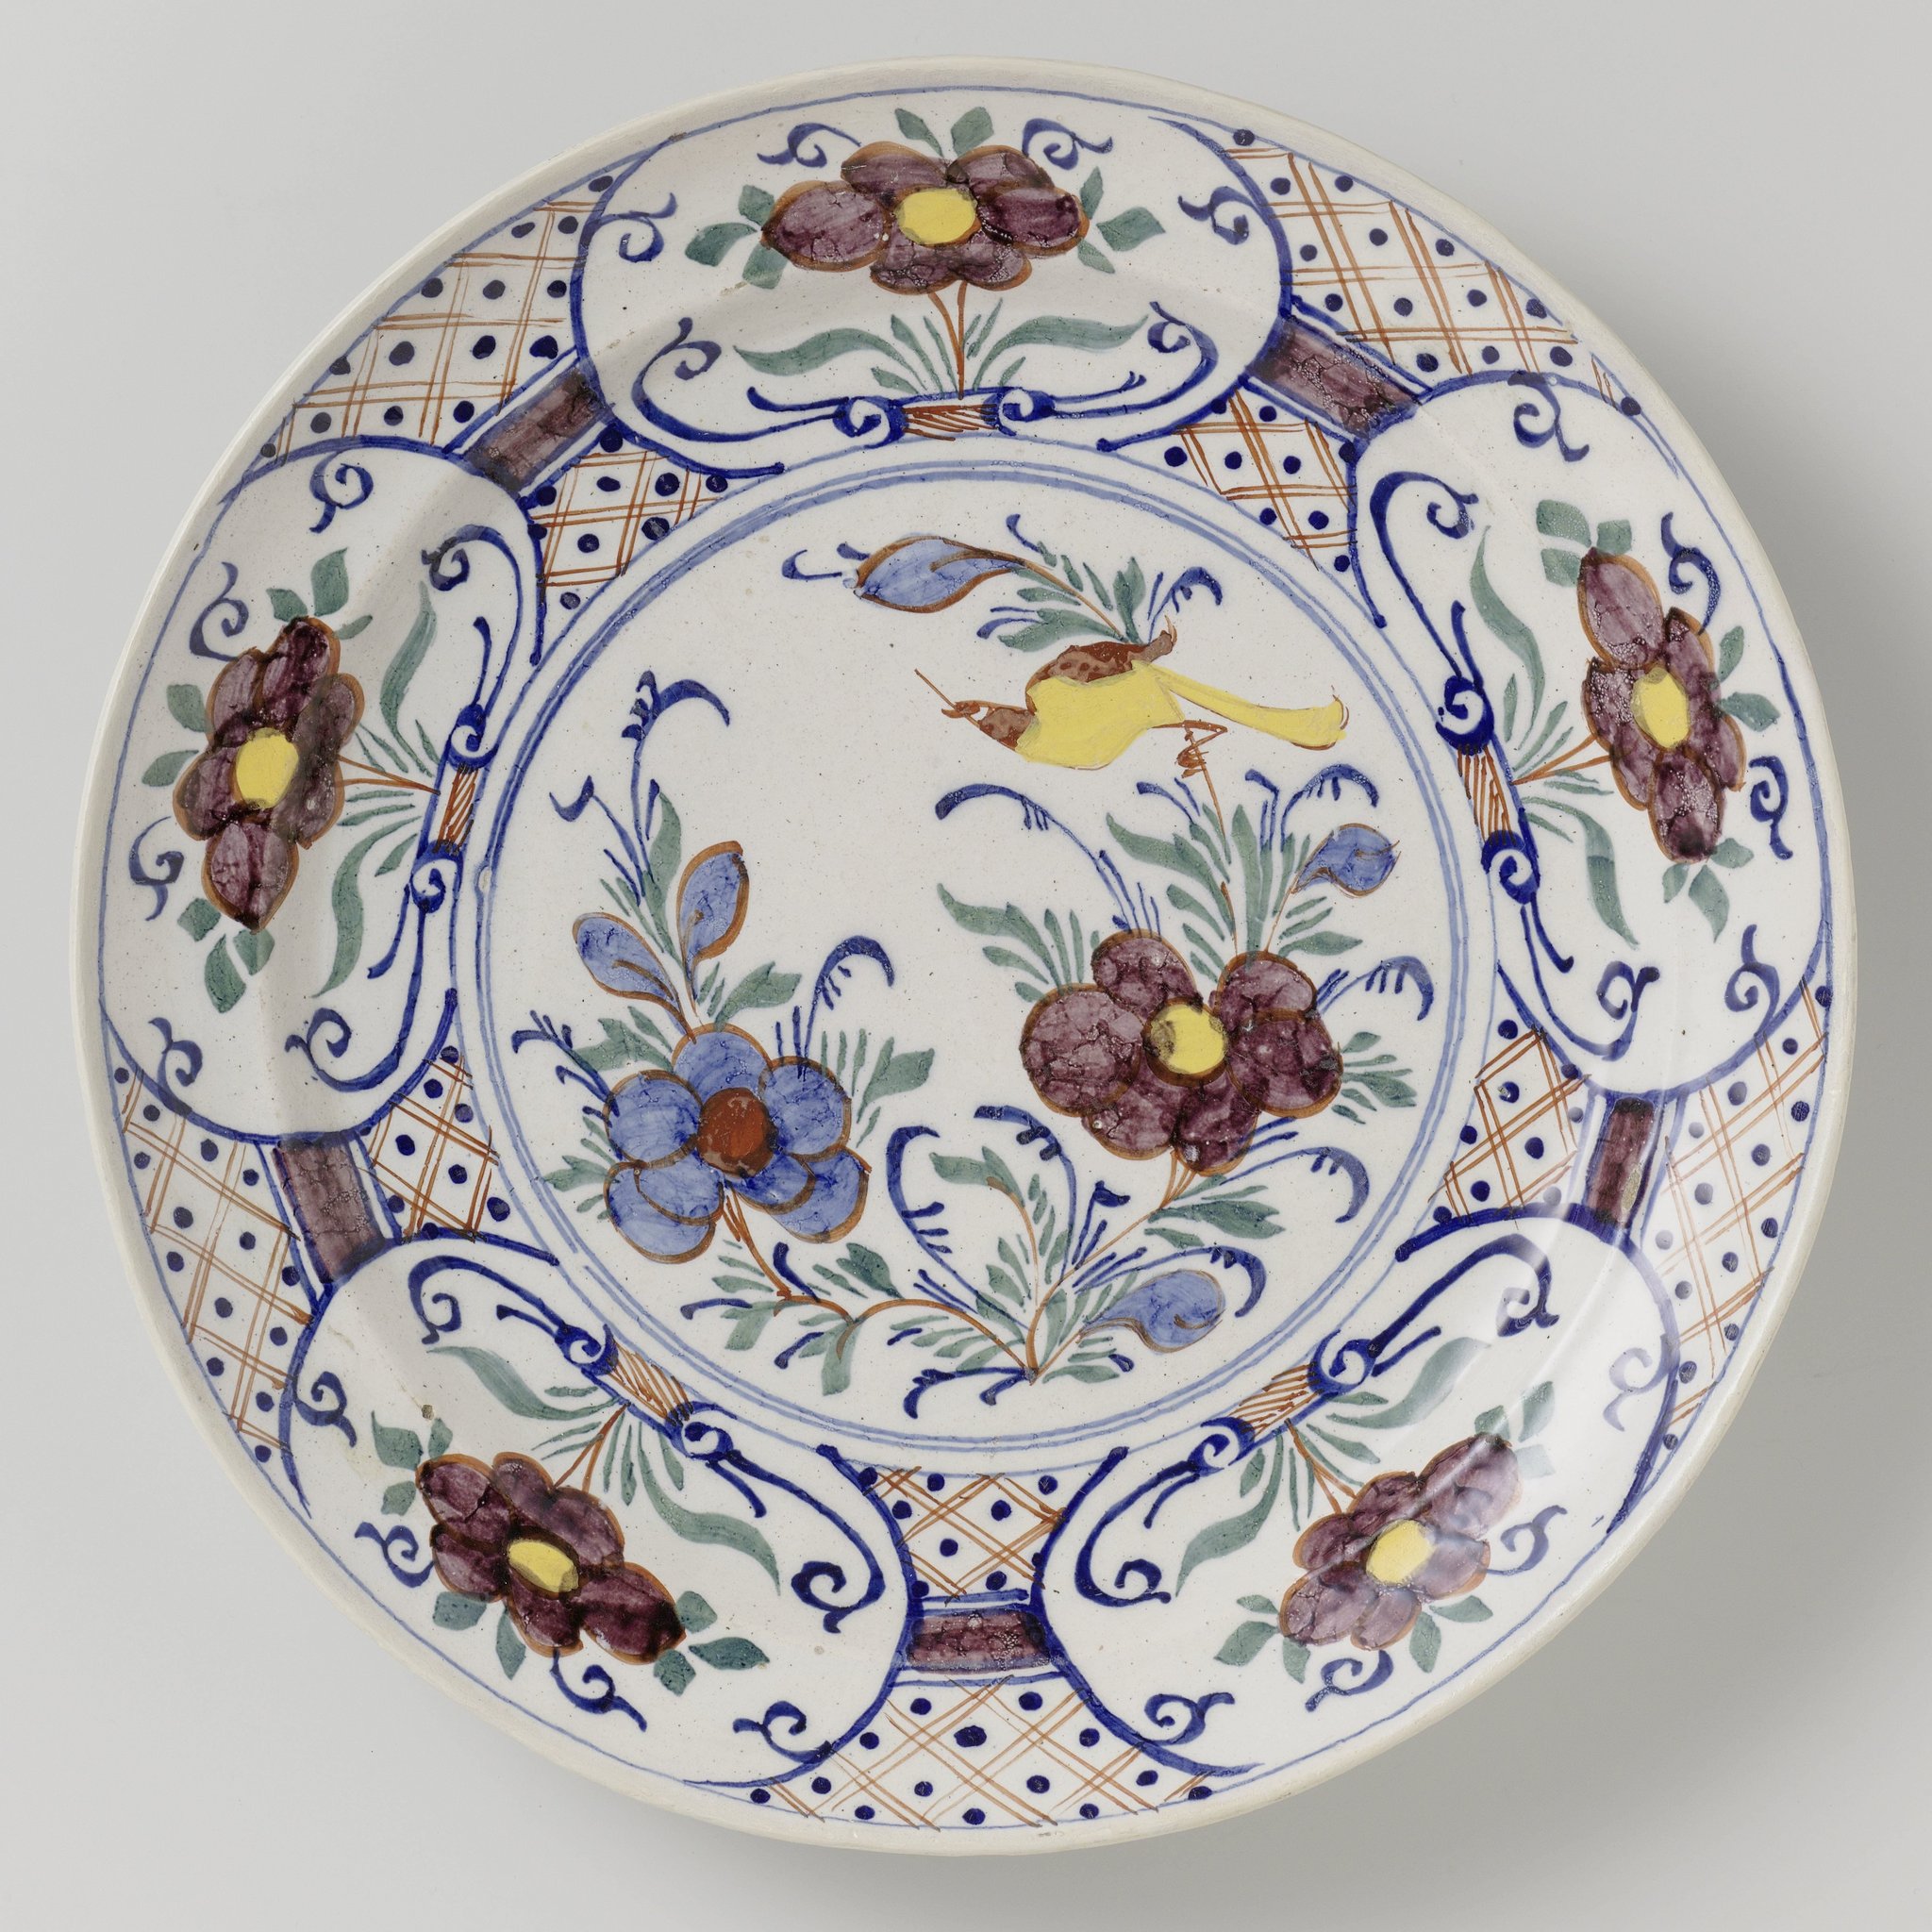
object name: platter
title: Schotel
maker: Anonymous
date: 1750-1780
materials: earthenware, glaze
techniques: painted, polychromy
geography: delft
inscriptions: seal: ‘2191/ U.D.’, mark: ‘onbekend merk met een V, waaronder een streep’, collector's mark: ‘koninklijk oudheidkundig genootschap no. 43’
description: Ronde schotel van veelkleurig beschilderde faience, met op het plat een cirkel waarbinnen een veelkleurige vogel en bloemen. Om de cirkel is een ruitmotief met stippen geschilderd, waarin vijf ovale vakken met bloemen in de kleuren geel en mangaan. De achterzijde is gemerkt met het getal 5.